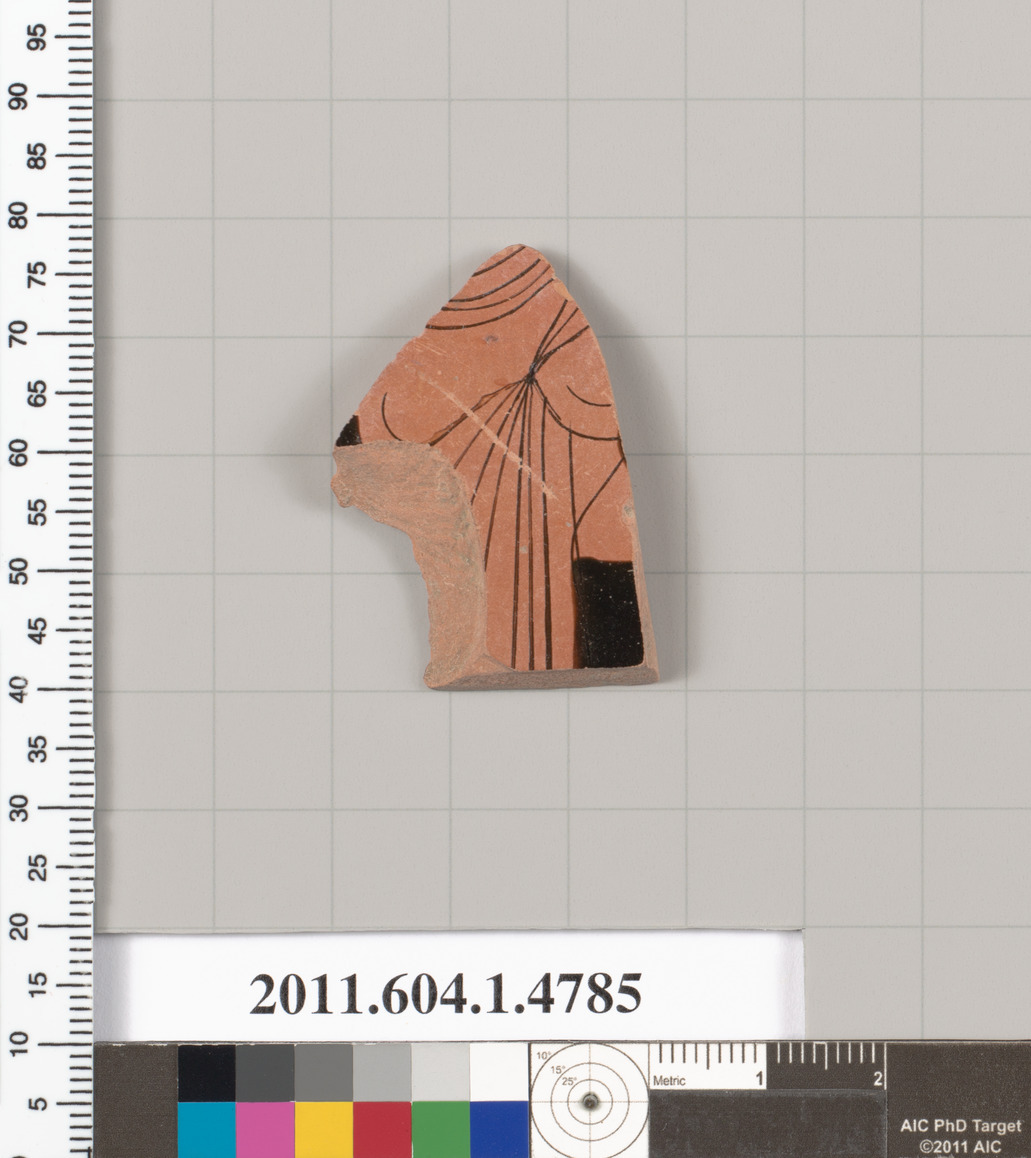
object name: kylix fragment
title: Terracotta fragment of a kylix (drinking cup)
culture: greek, attic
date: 475-451 BCE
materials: terracotta